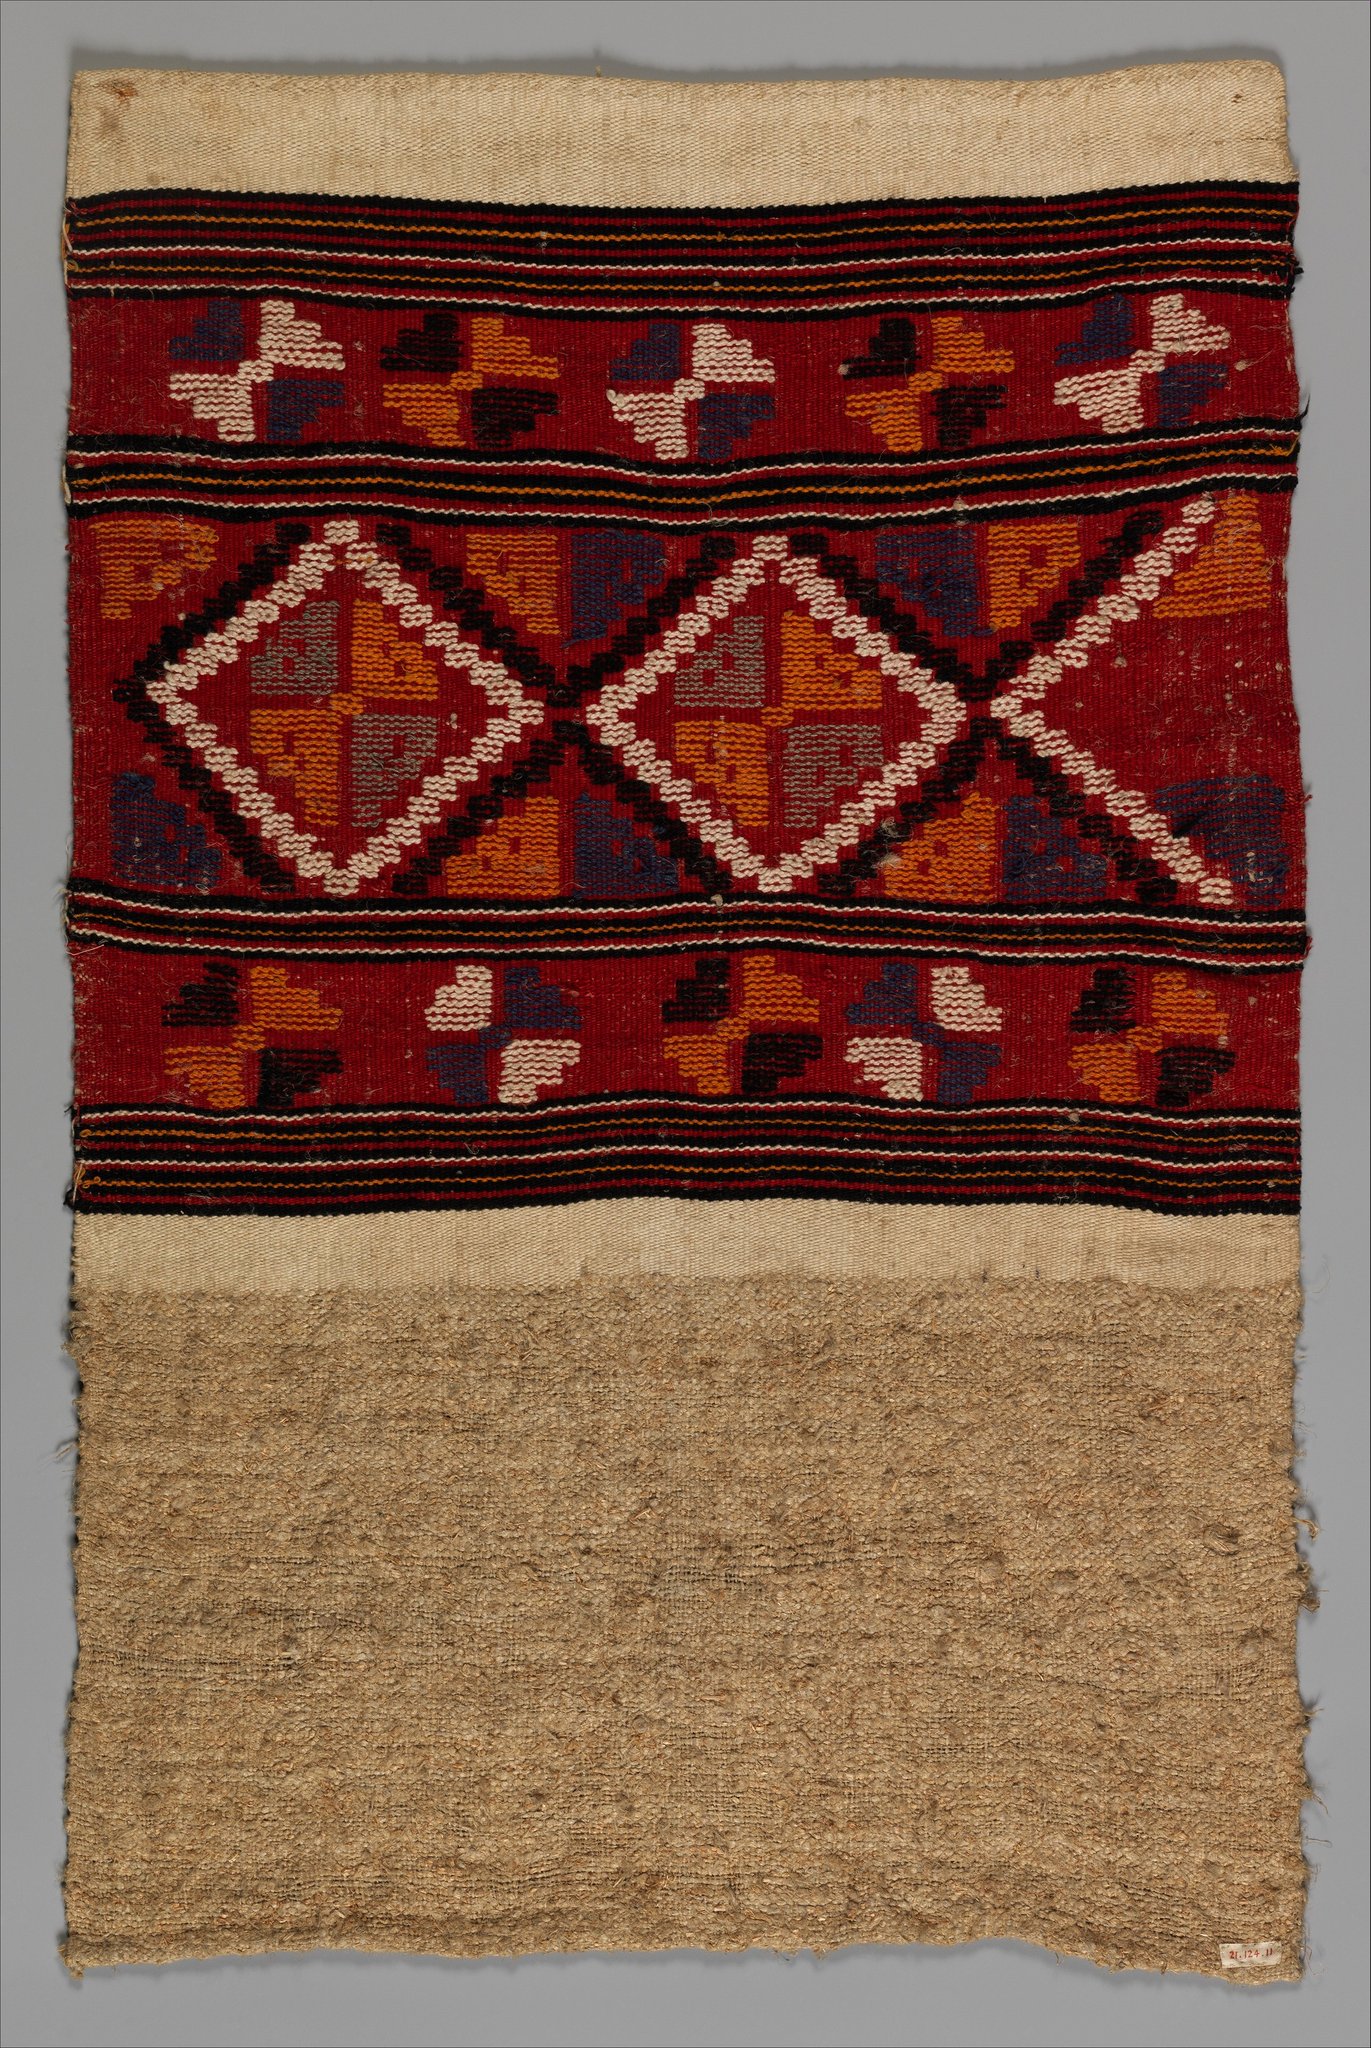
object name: towel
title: Towel “Prosop de Culme”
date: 1801-1900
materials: cotton, hemp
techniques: dyeing, weave